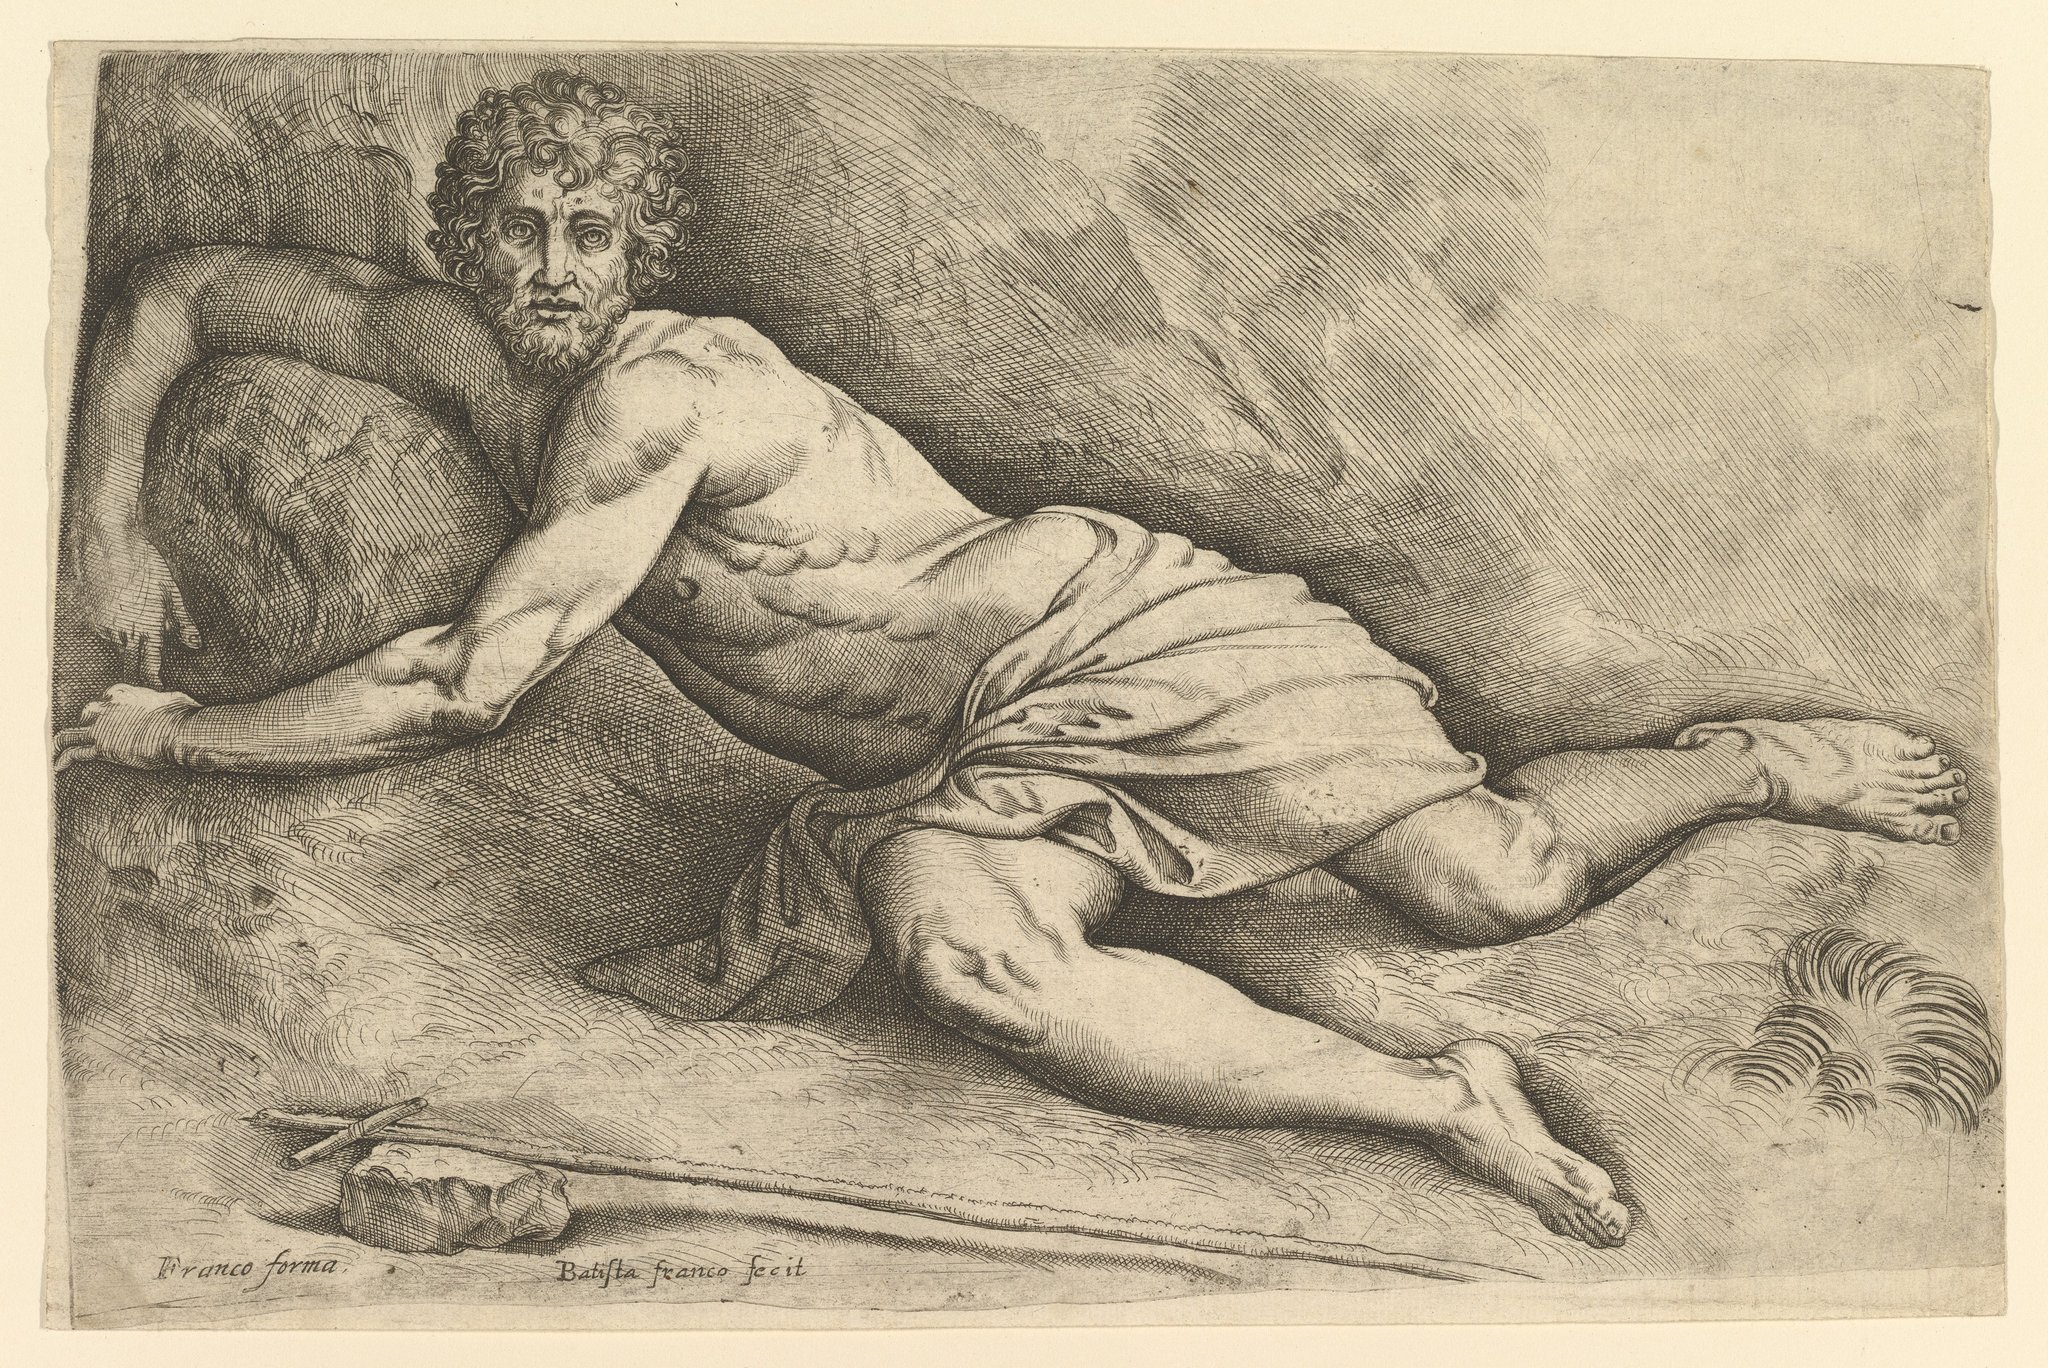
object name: print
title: St. John the Baptist in the Wilderness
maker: battista franco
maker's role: artist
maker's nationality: italian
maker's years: 1510-1561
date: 1552-1554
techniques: engraving, etching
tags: saint john the baptist,cross